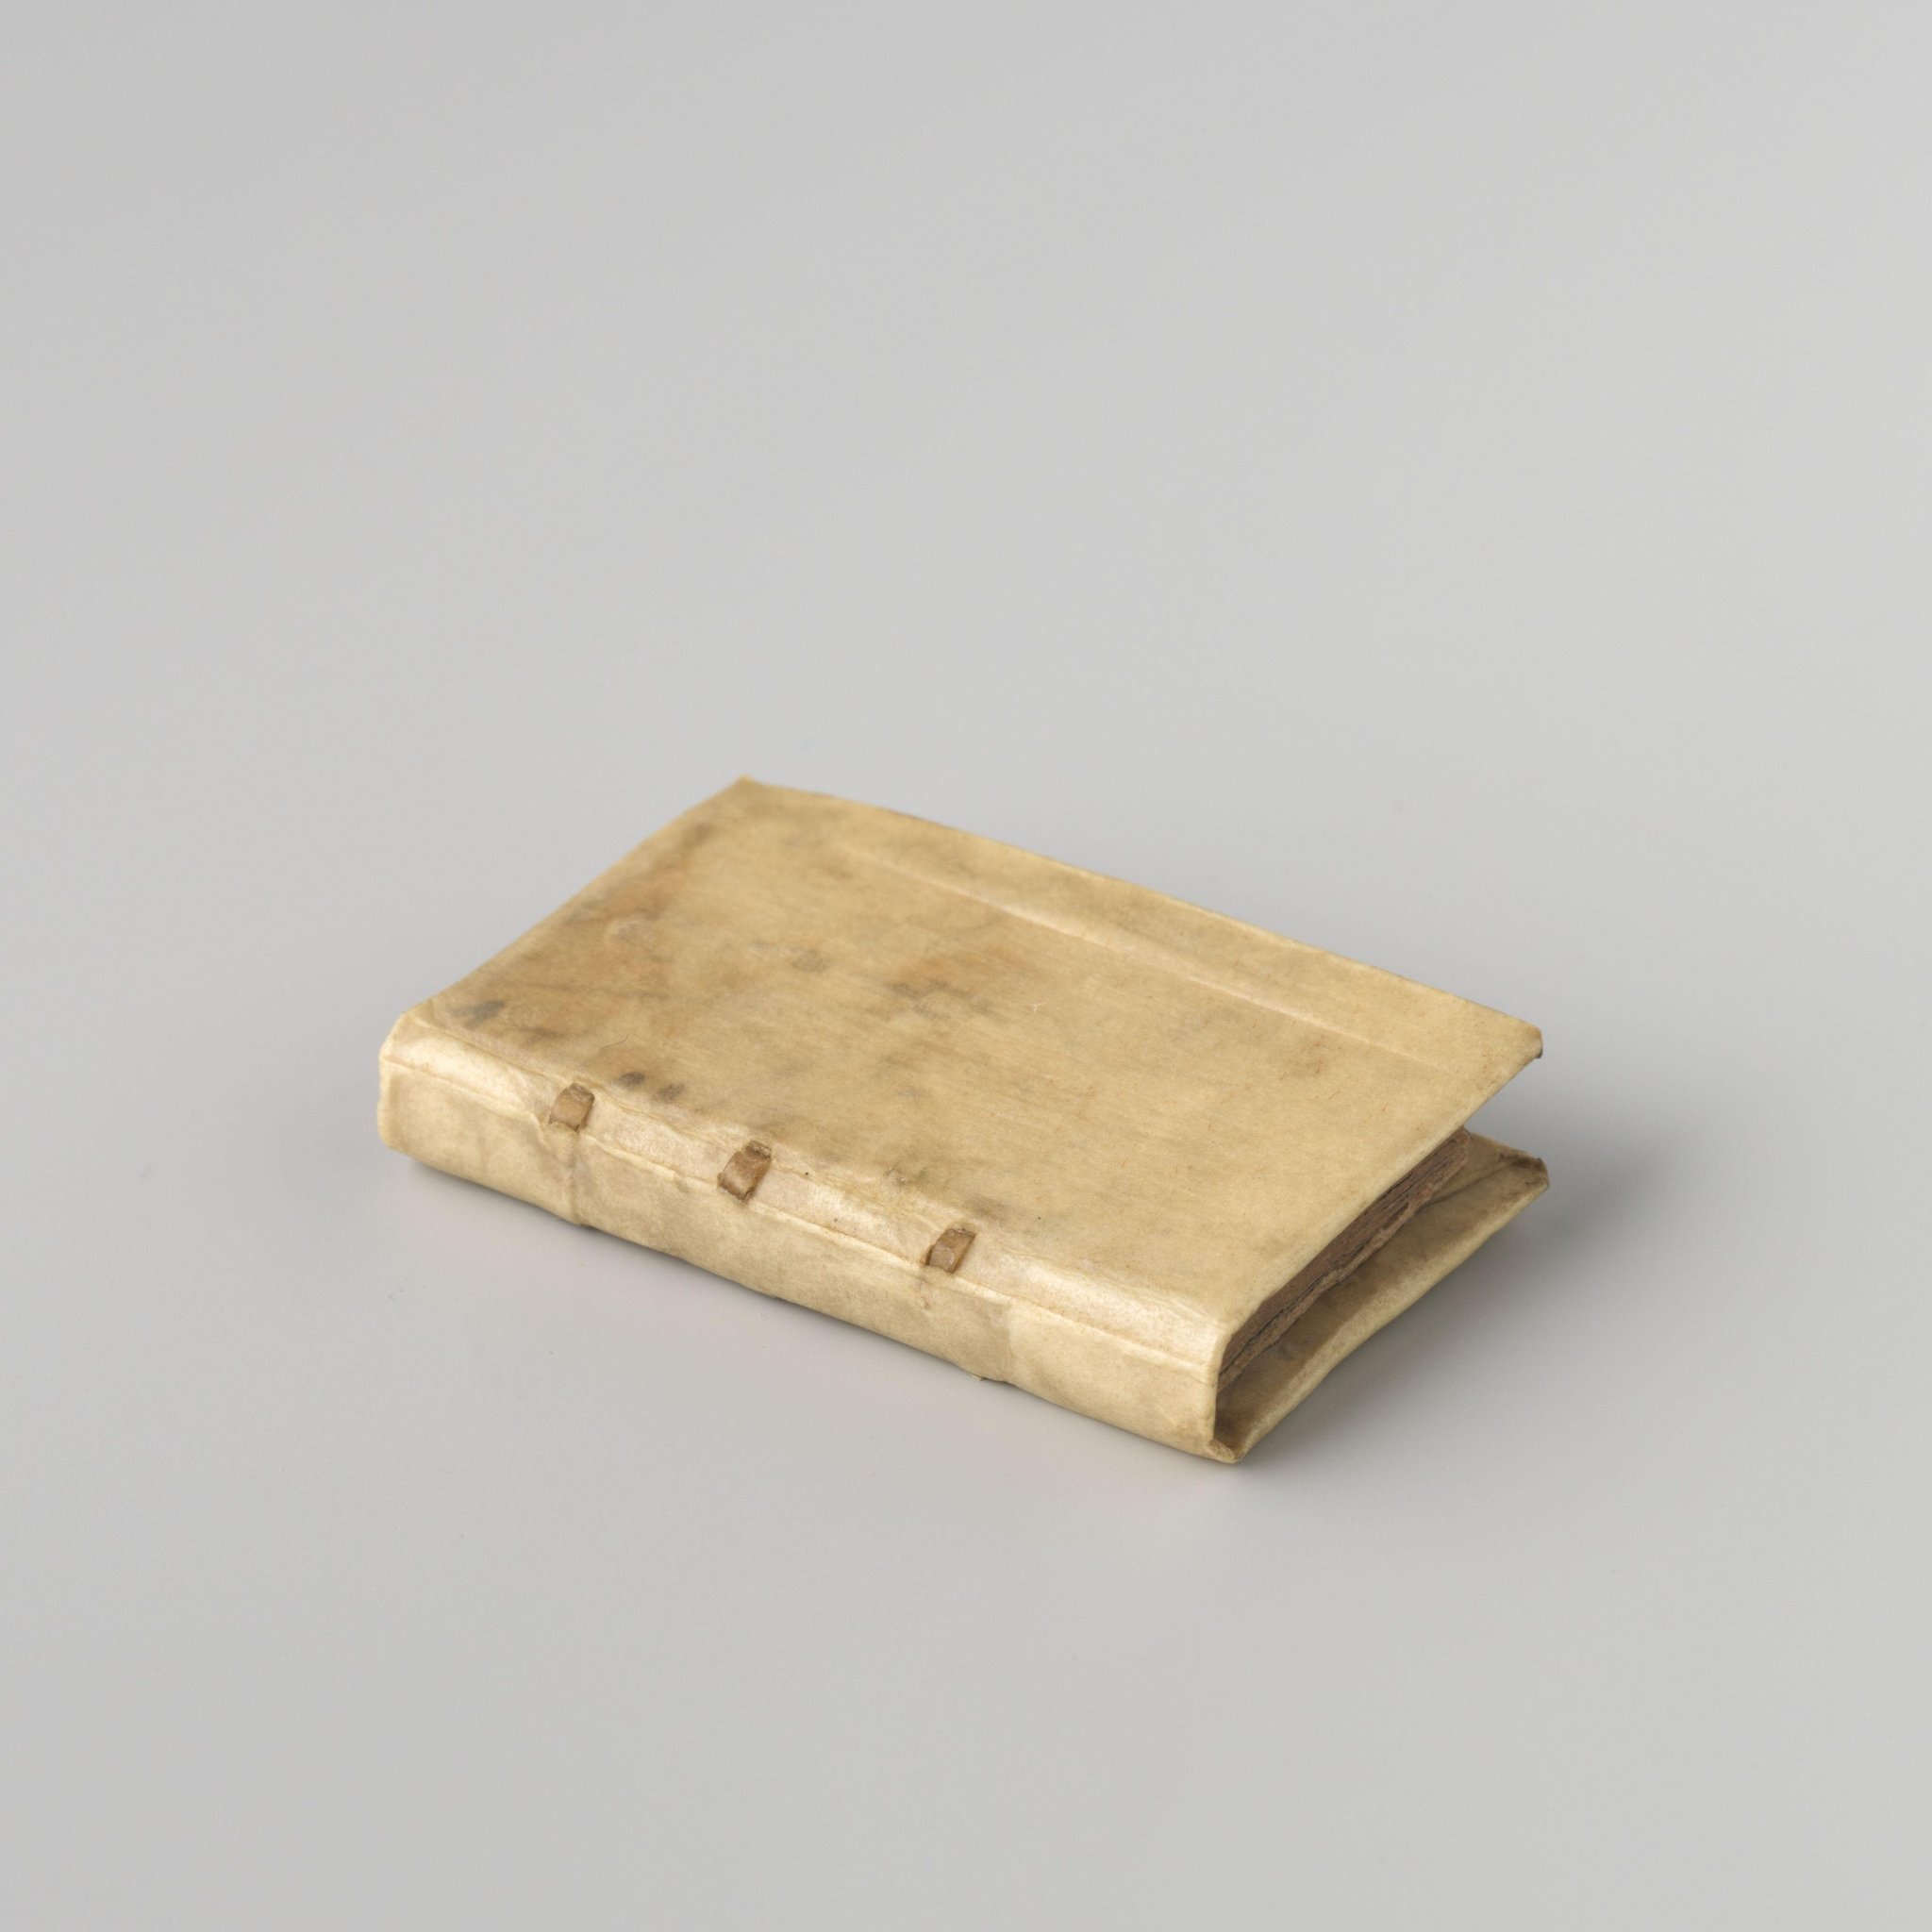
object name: album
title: Van de Pausen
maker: Anonymous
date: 1676-1689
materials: paper, parchment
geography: amsterdam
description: Eén van 6 boeken uit een serie van oorspronkelijk 10; gebonden in blank perkament (zg. splitsel binding), hergebruikt (makulatuur) snede, ongekleurd. 4 katernen van 4 plakstroken. De bladzijden zijn aan de plakstroken geplakt recto en verso, geknipt uit een langestrook met koppen van 25 pausen, voorafgegaan door geschreven tekst: Omnium pontigicuma S. Petro Usque an Praesentem effigies ab antiquis diligenter extractus. "Het tweede deel van de Pausen". Uitgeknipt uit een tussen 1676 en 1689 uitgegeven prent.